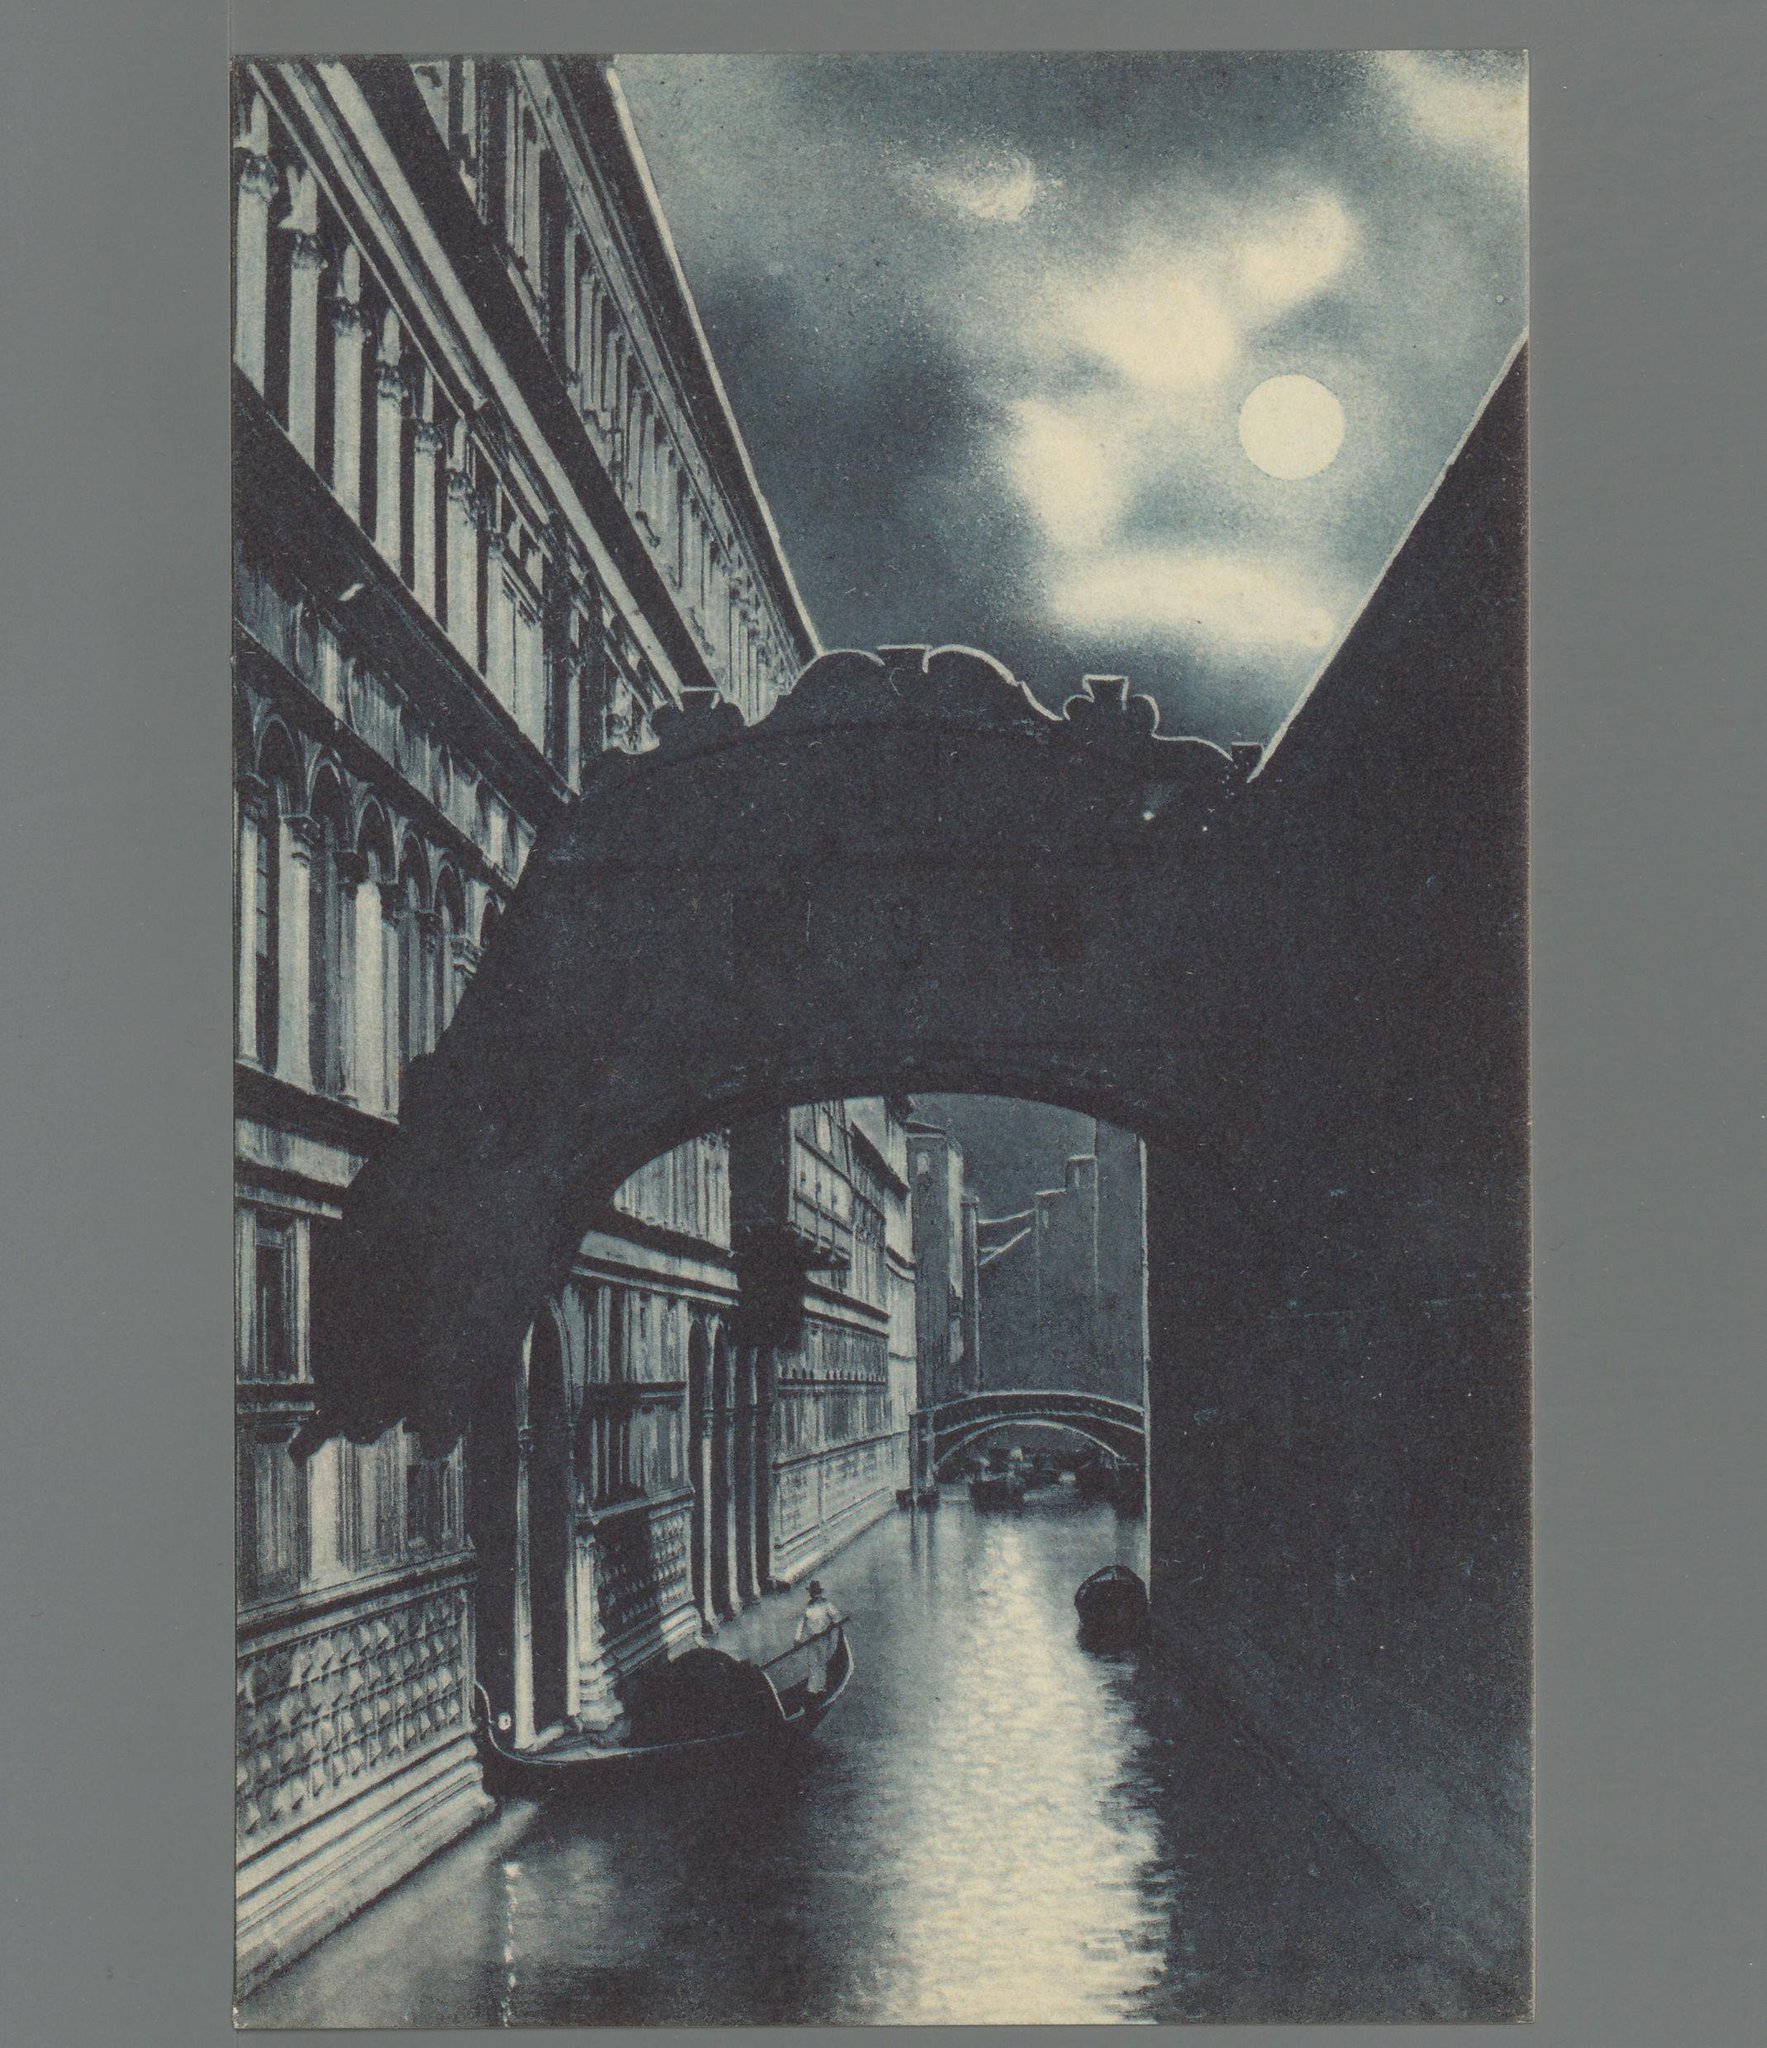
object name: ansichtkaart, prentbriefkaart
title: Venezia. Ponte dei Sospiri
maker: Anonymous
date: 1900-1905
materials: cardboard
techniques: photograph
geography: venice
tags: river, moonlight, bridge in city across river, canal, etc.